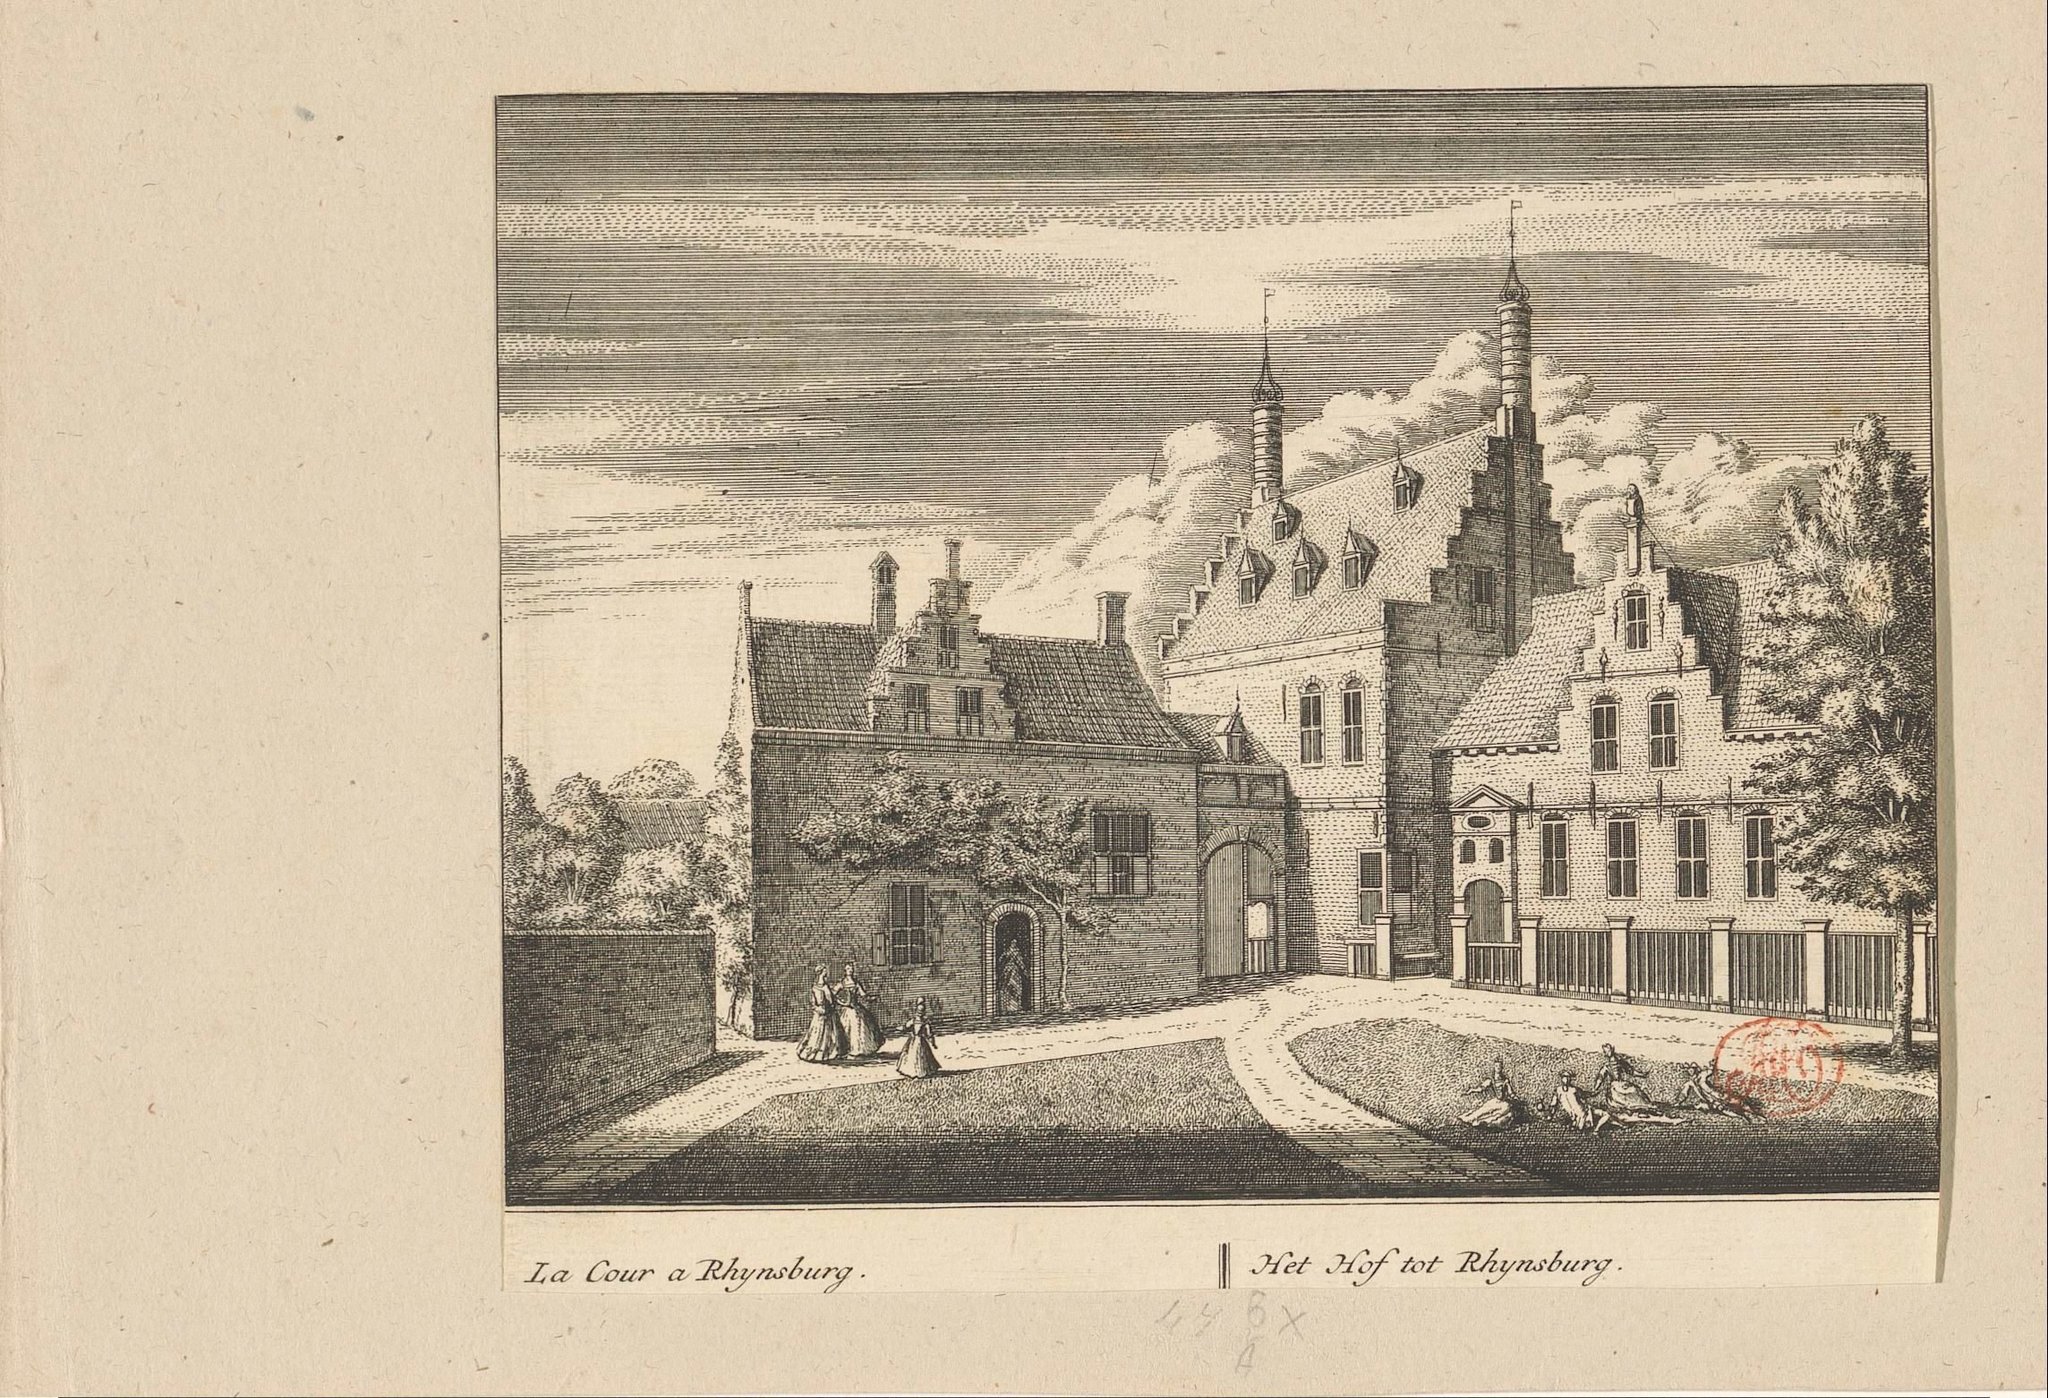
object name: book illustration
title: Gezicht op het Hof van Rijnsburg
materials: paper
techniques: etching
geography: amsterdam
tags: rijnsburg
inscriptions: collector's mark: Lugt 195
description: Prent ook gebruikt in: Rademaker, Abraham. Rhynlands fraaiste gezichten; vertonende alle deszelfs lustplaatzen, heeren-huizen en dorpen. Van halfwegen Haarlem en Leyden (…) / Les plus agréables vuës de Rhynland, representant toutes les maisons de plaisance, maisons seigneuriales & villages. Commençant à demilieu Haarlem & Leyden (…). Ansterdam: Leonard Schenk, 1732.